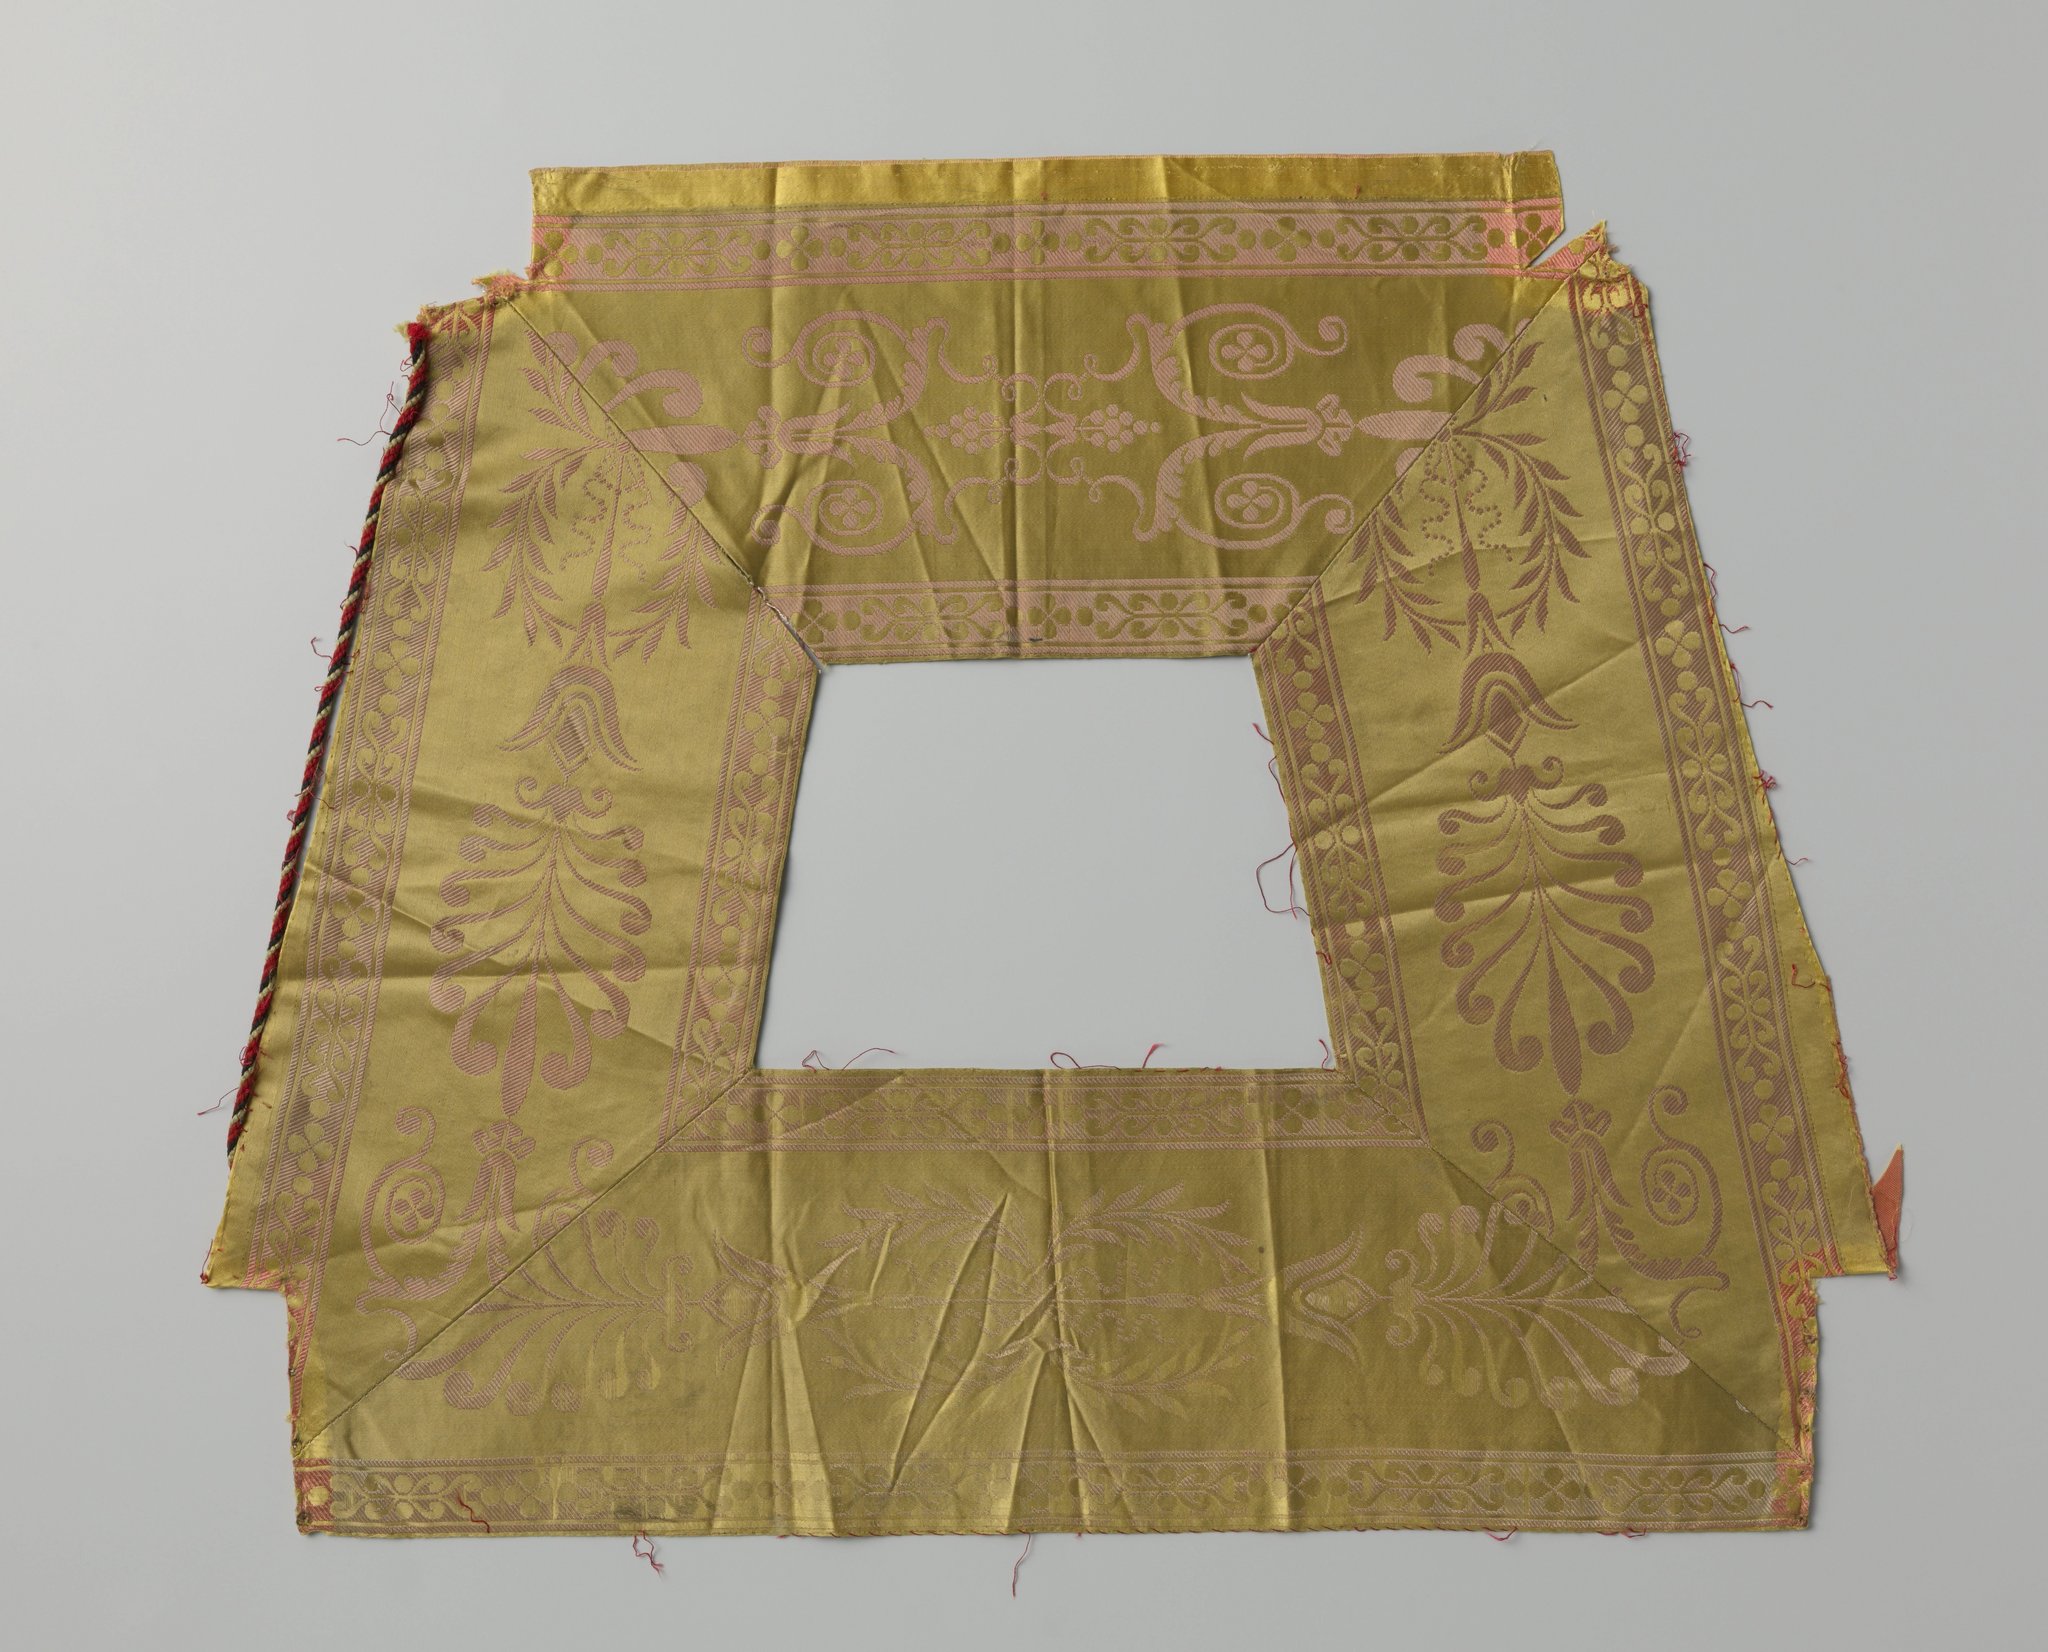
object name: stoelbekleding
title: Fragment zijdeweefsel van een stoelbekleding.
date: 1805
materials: silk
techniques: brocade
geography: france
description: Fragment geel zijdeweefsel, van een stoelbekleding. Het patroon heeft op een gele grond roze palmetten en arabesken. Het fragment hoort bij dertien fragmenten met invnr. BK-1992-18-A t/m BK-1992-18-M.